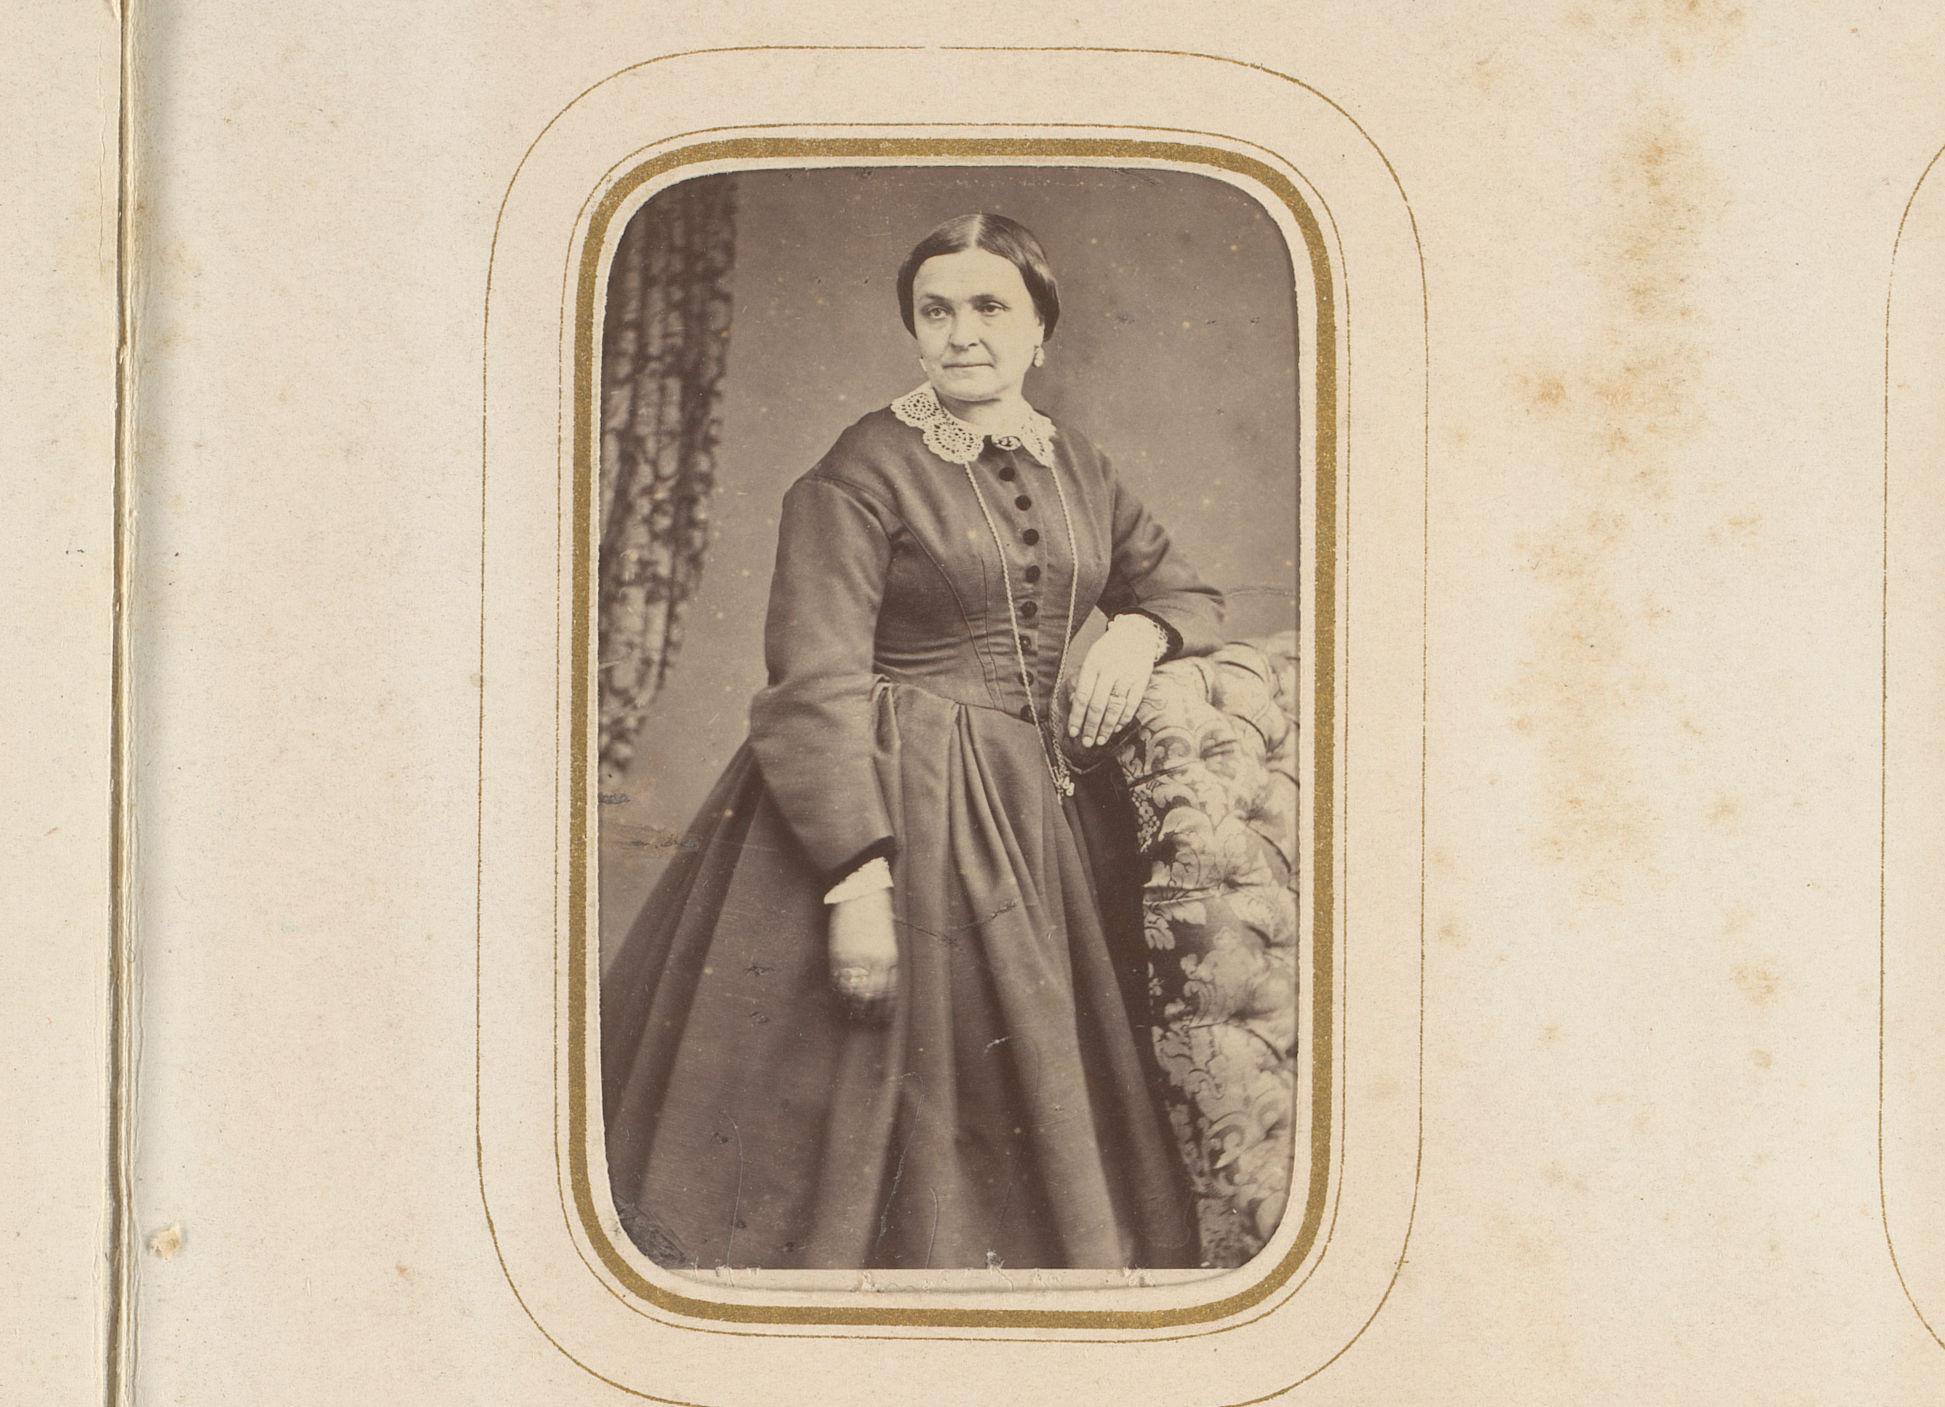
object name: album leaf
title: Portret van een staande vrouw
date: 1860-1890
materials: cardboard, photographic support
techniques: albumen print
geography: paris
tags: historical persons - bb - woman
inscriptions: inscription: ‘Photographie Parisienne/ Jarad & Brotonnière/ Grande-Côte, 14/ Lyon’, inscription: ‘Janard & Brotonnière Phot.’